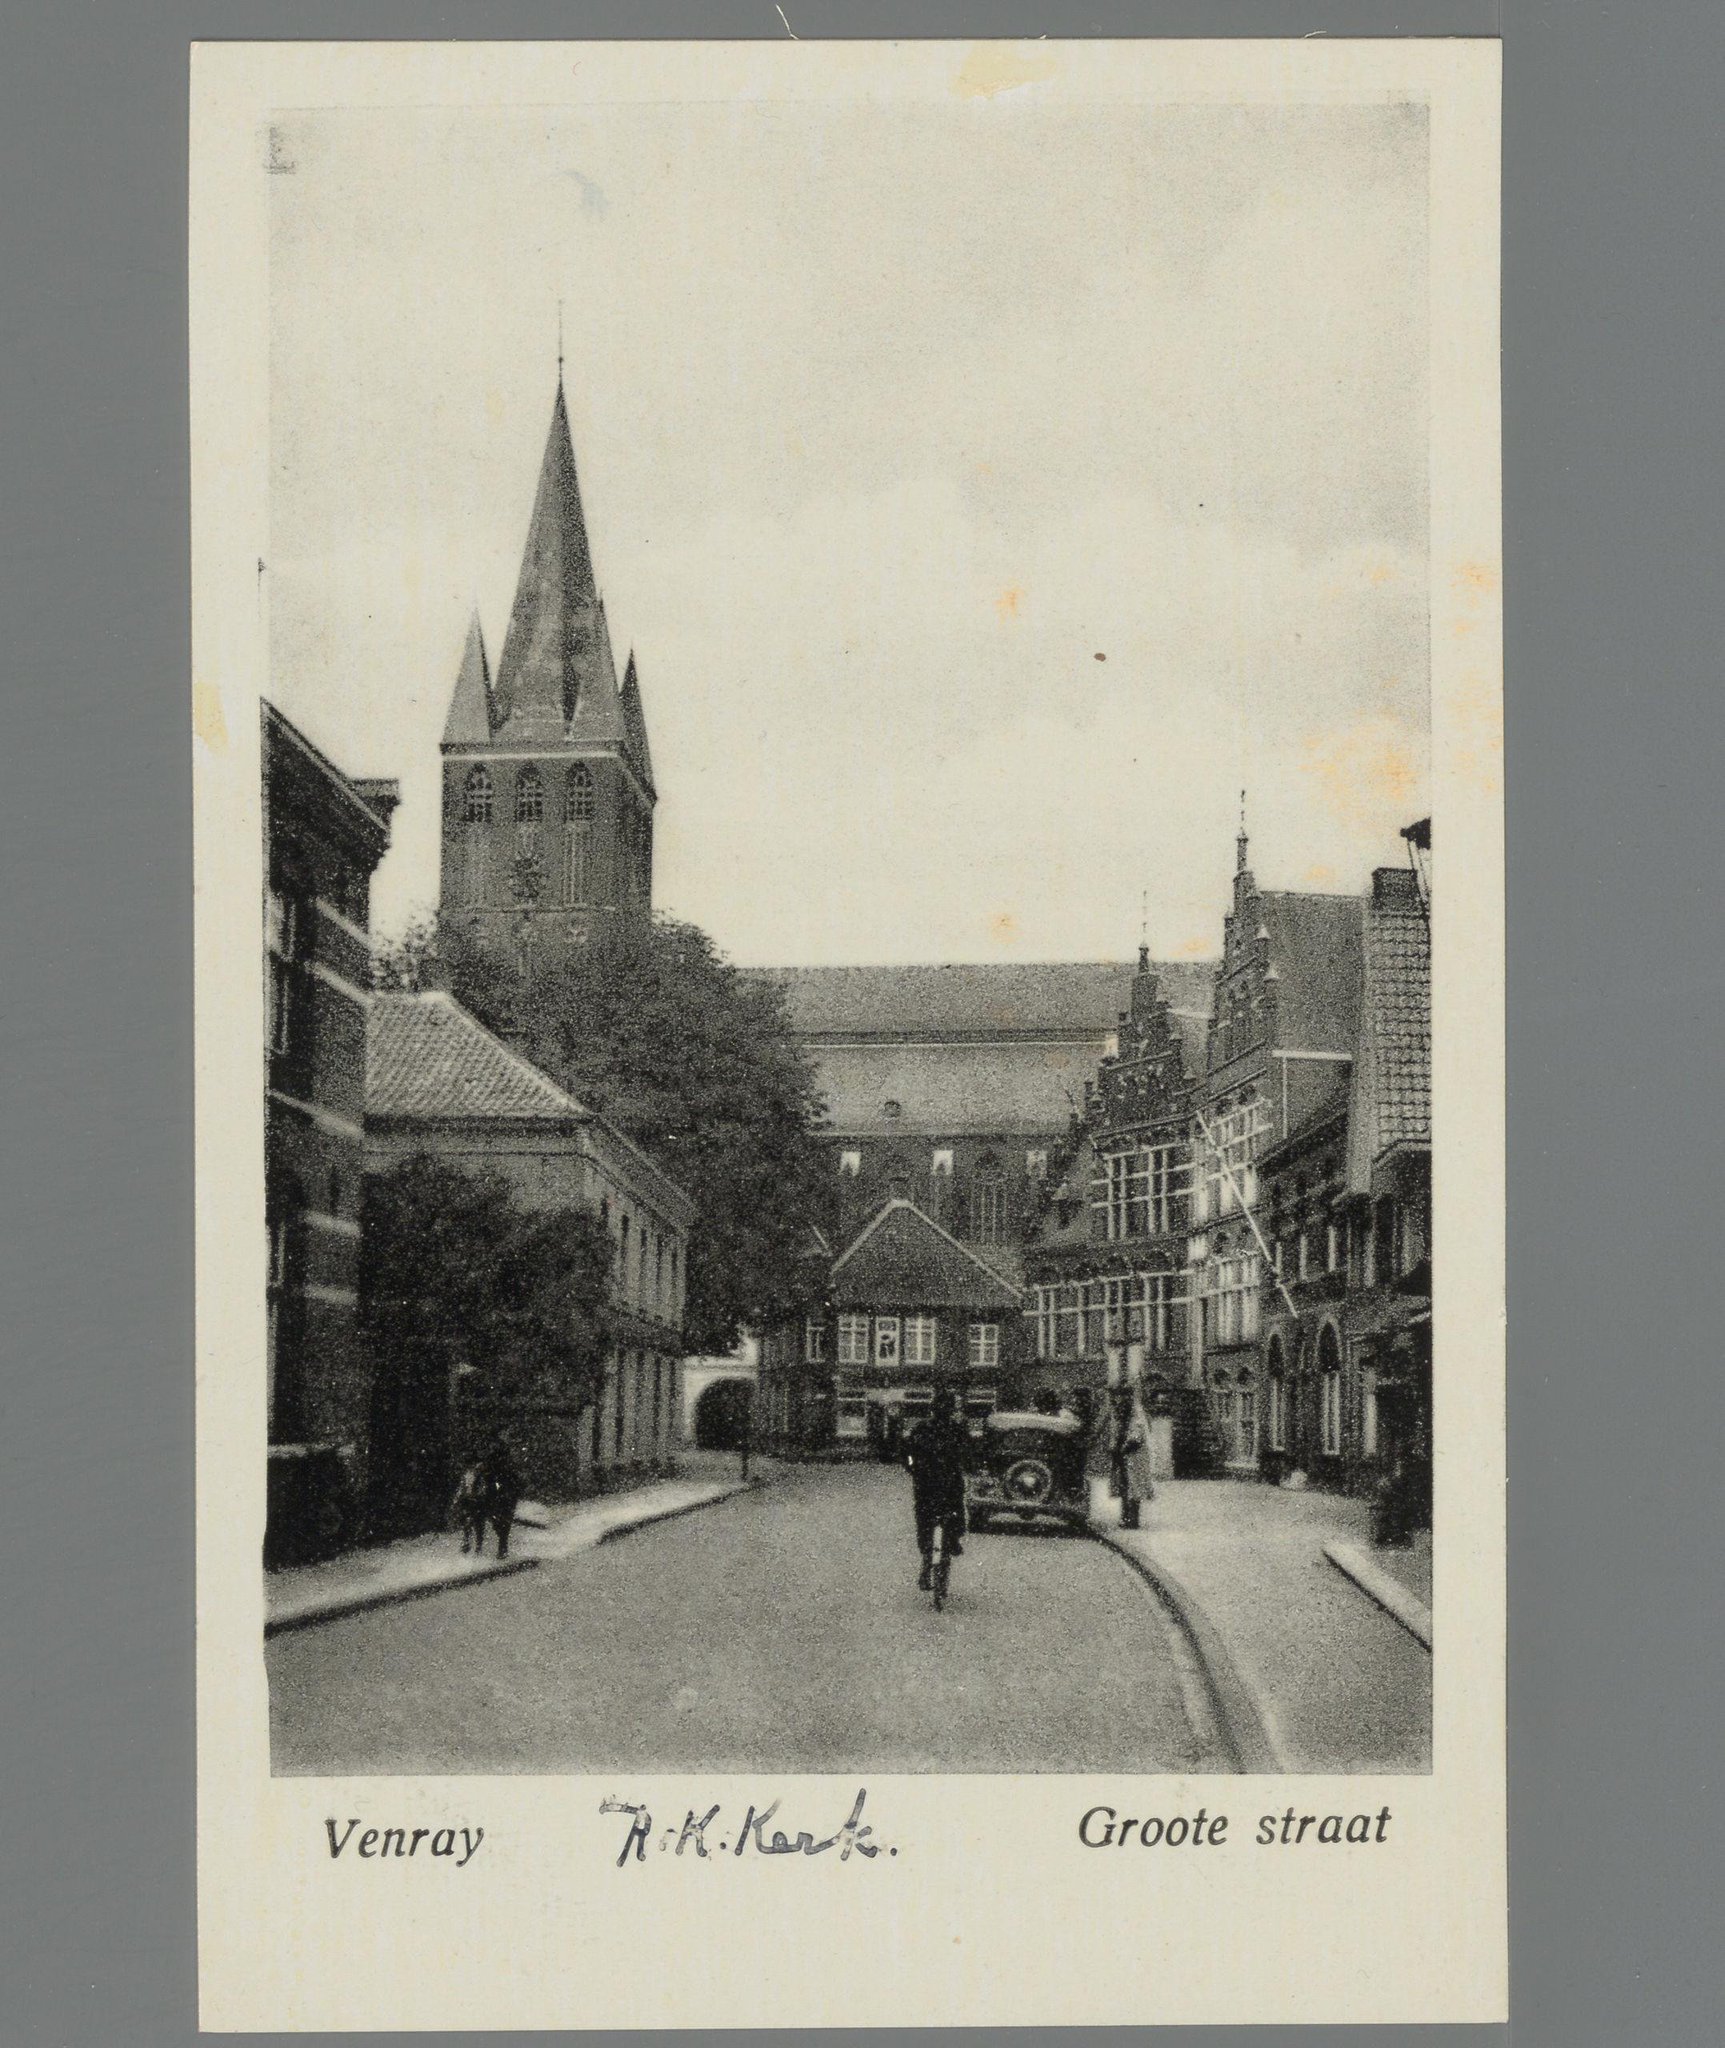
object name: ansichtkaart, prentbriefkaart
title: Venray. Groote straat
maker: Anonymous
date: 1930-1950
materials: cardboard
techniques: photograph, writing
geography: the hague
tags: church (exterior), street